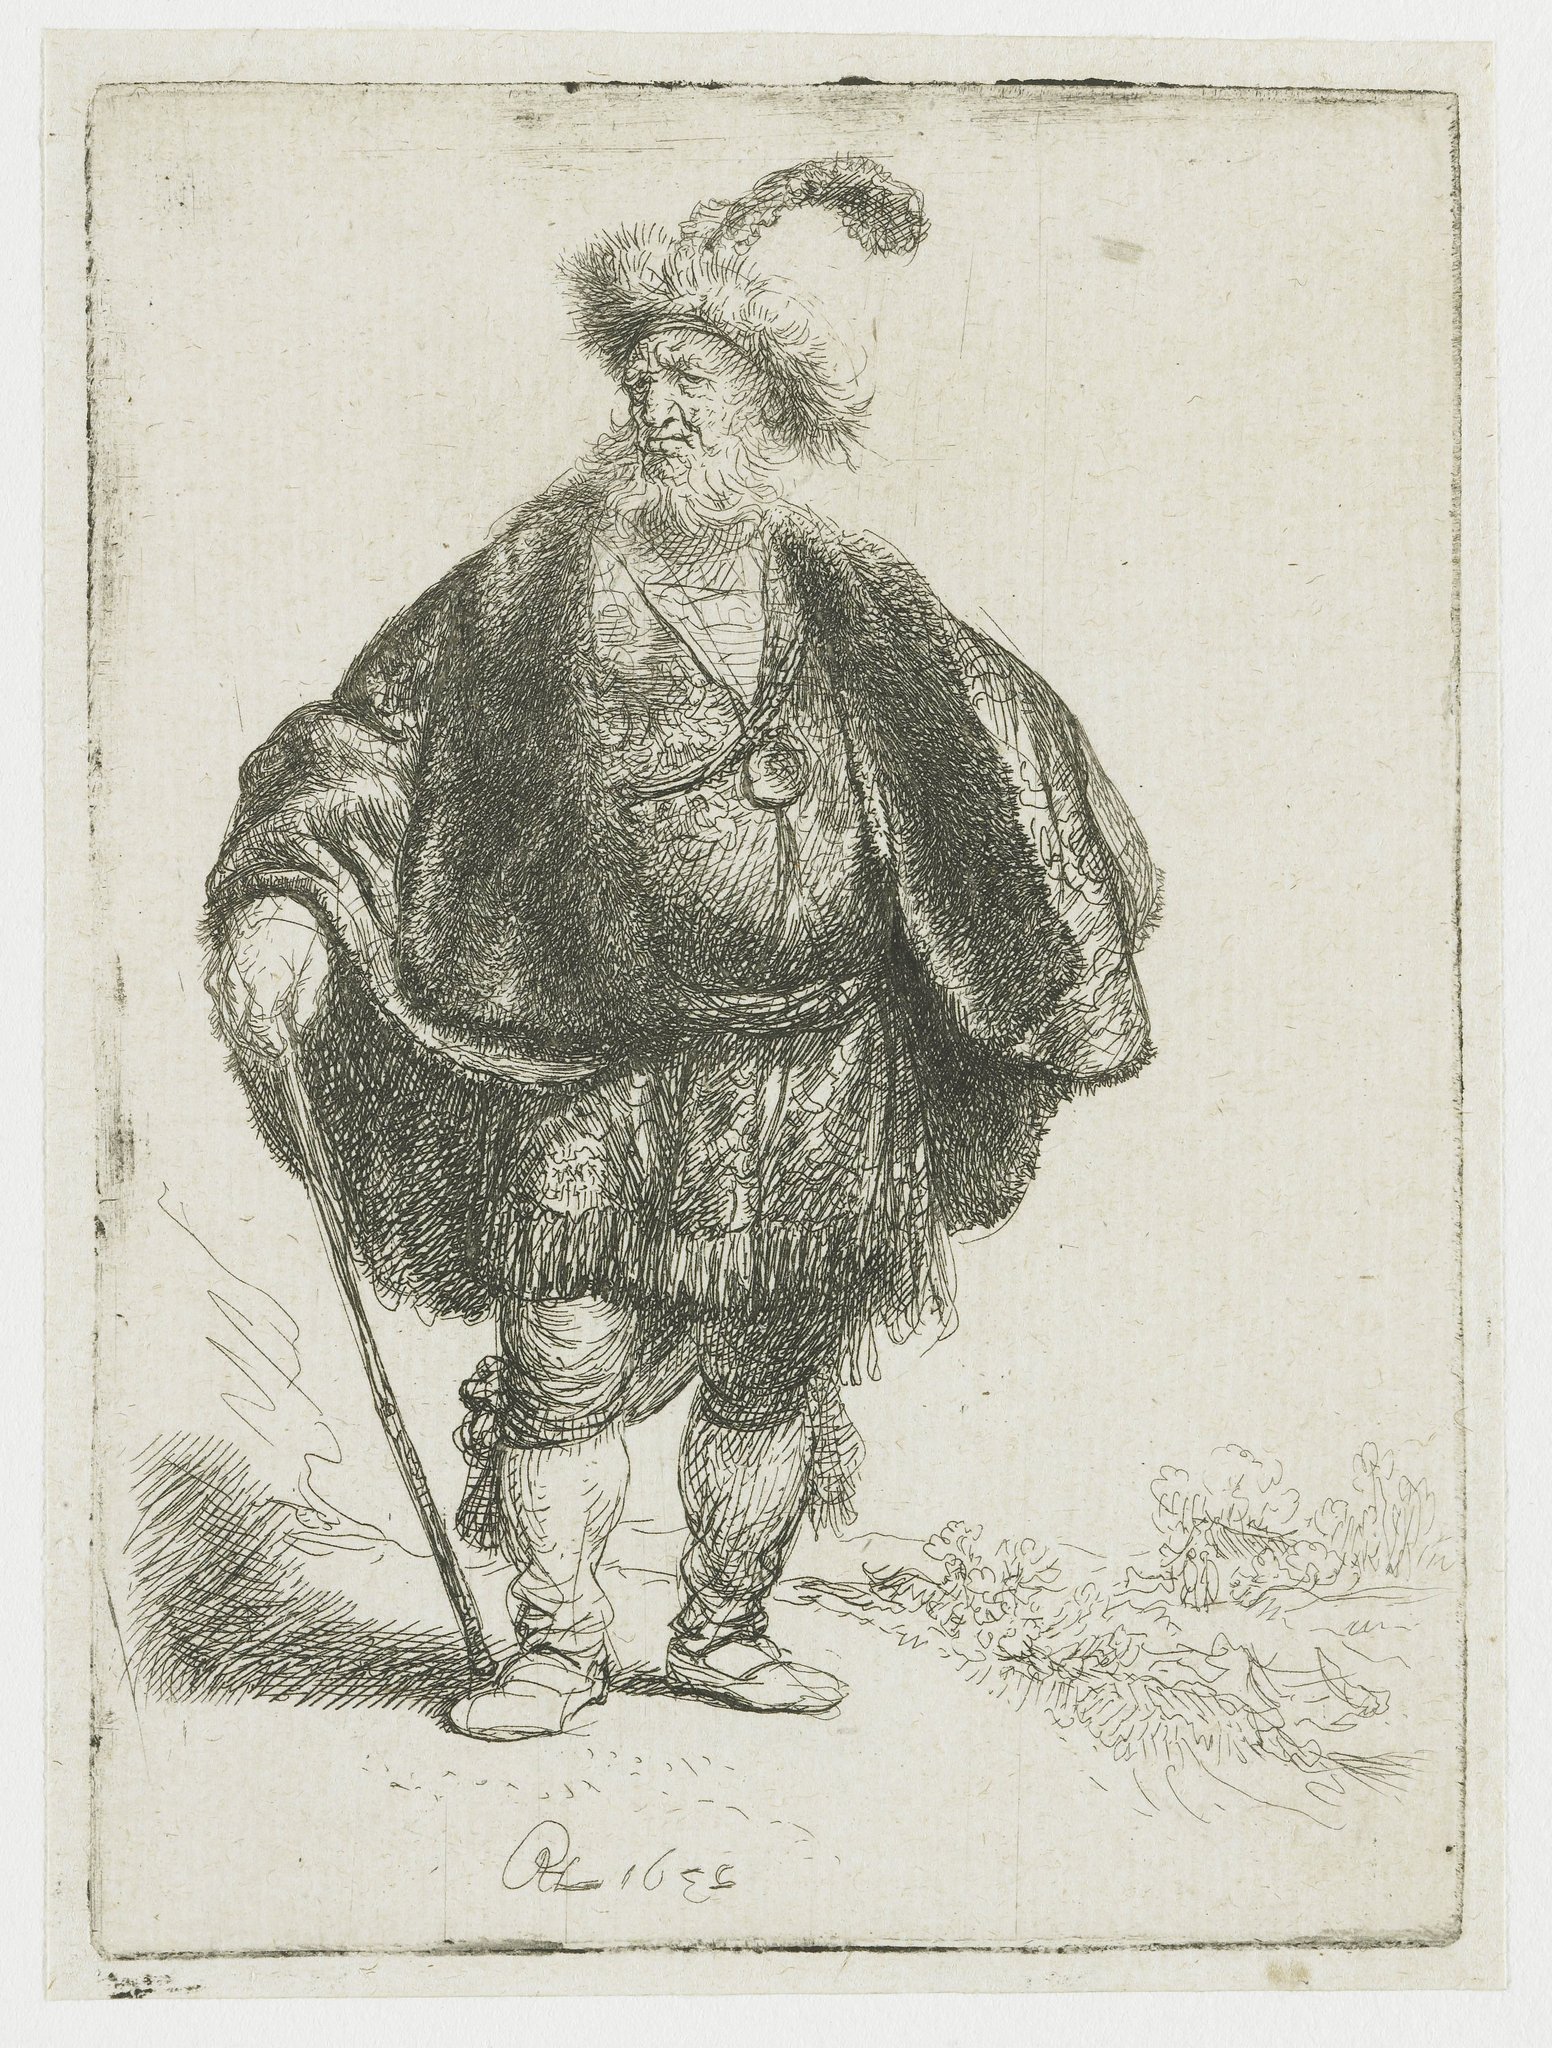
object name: print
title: The Persian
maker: rembrandt van rijn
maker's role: draughtsman, painter, print maker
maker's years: 1606-1669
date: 1632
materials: paper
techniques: etching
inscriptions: collector's mark: Lugt 240, monogram and date: ‘RHL 1632’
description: Already in the 18th century this print was known as ‘het Persiaantje’ (the little Persian), because the man’s clothing was perceived as having Oriental features. However, it is not genuine Iranian costume. Although Rembrandt lavished attention on rendering the fabrics, it remains an imaginary, pieced together outfit. This is actually a tronie, but then a full-length one.